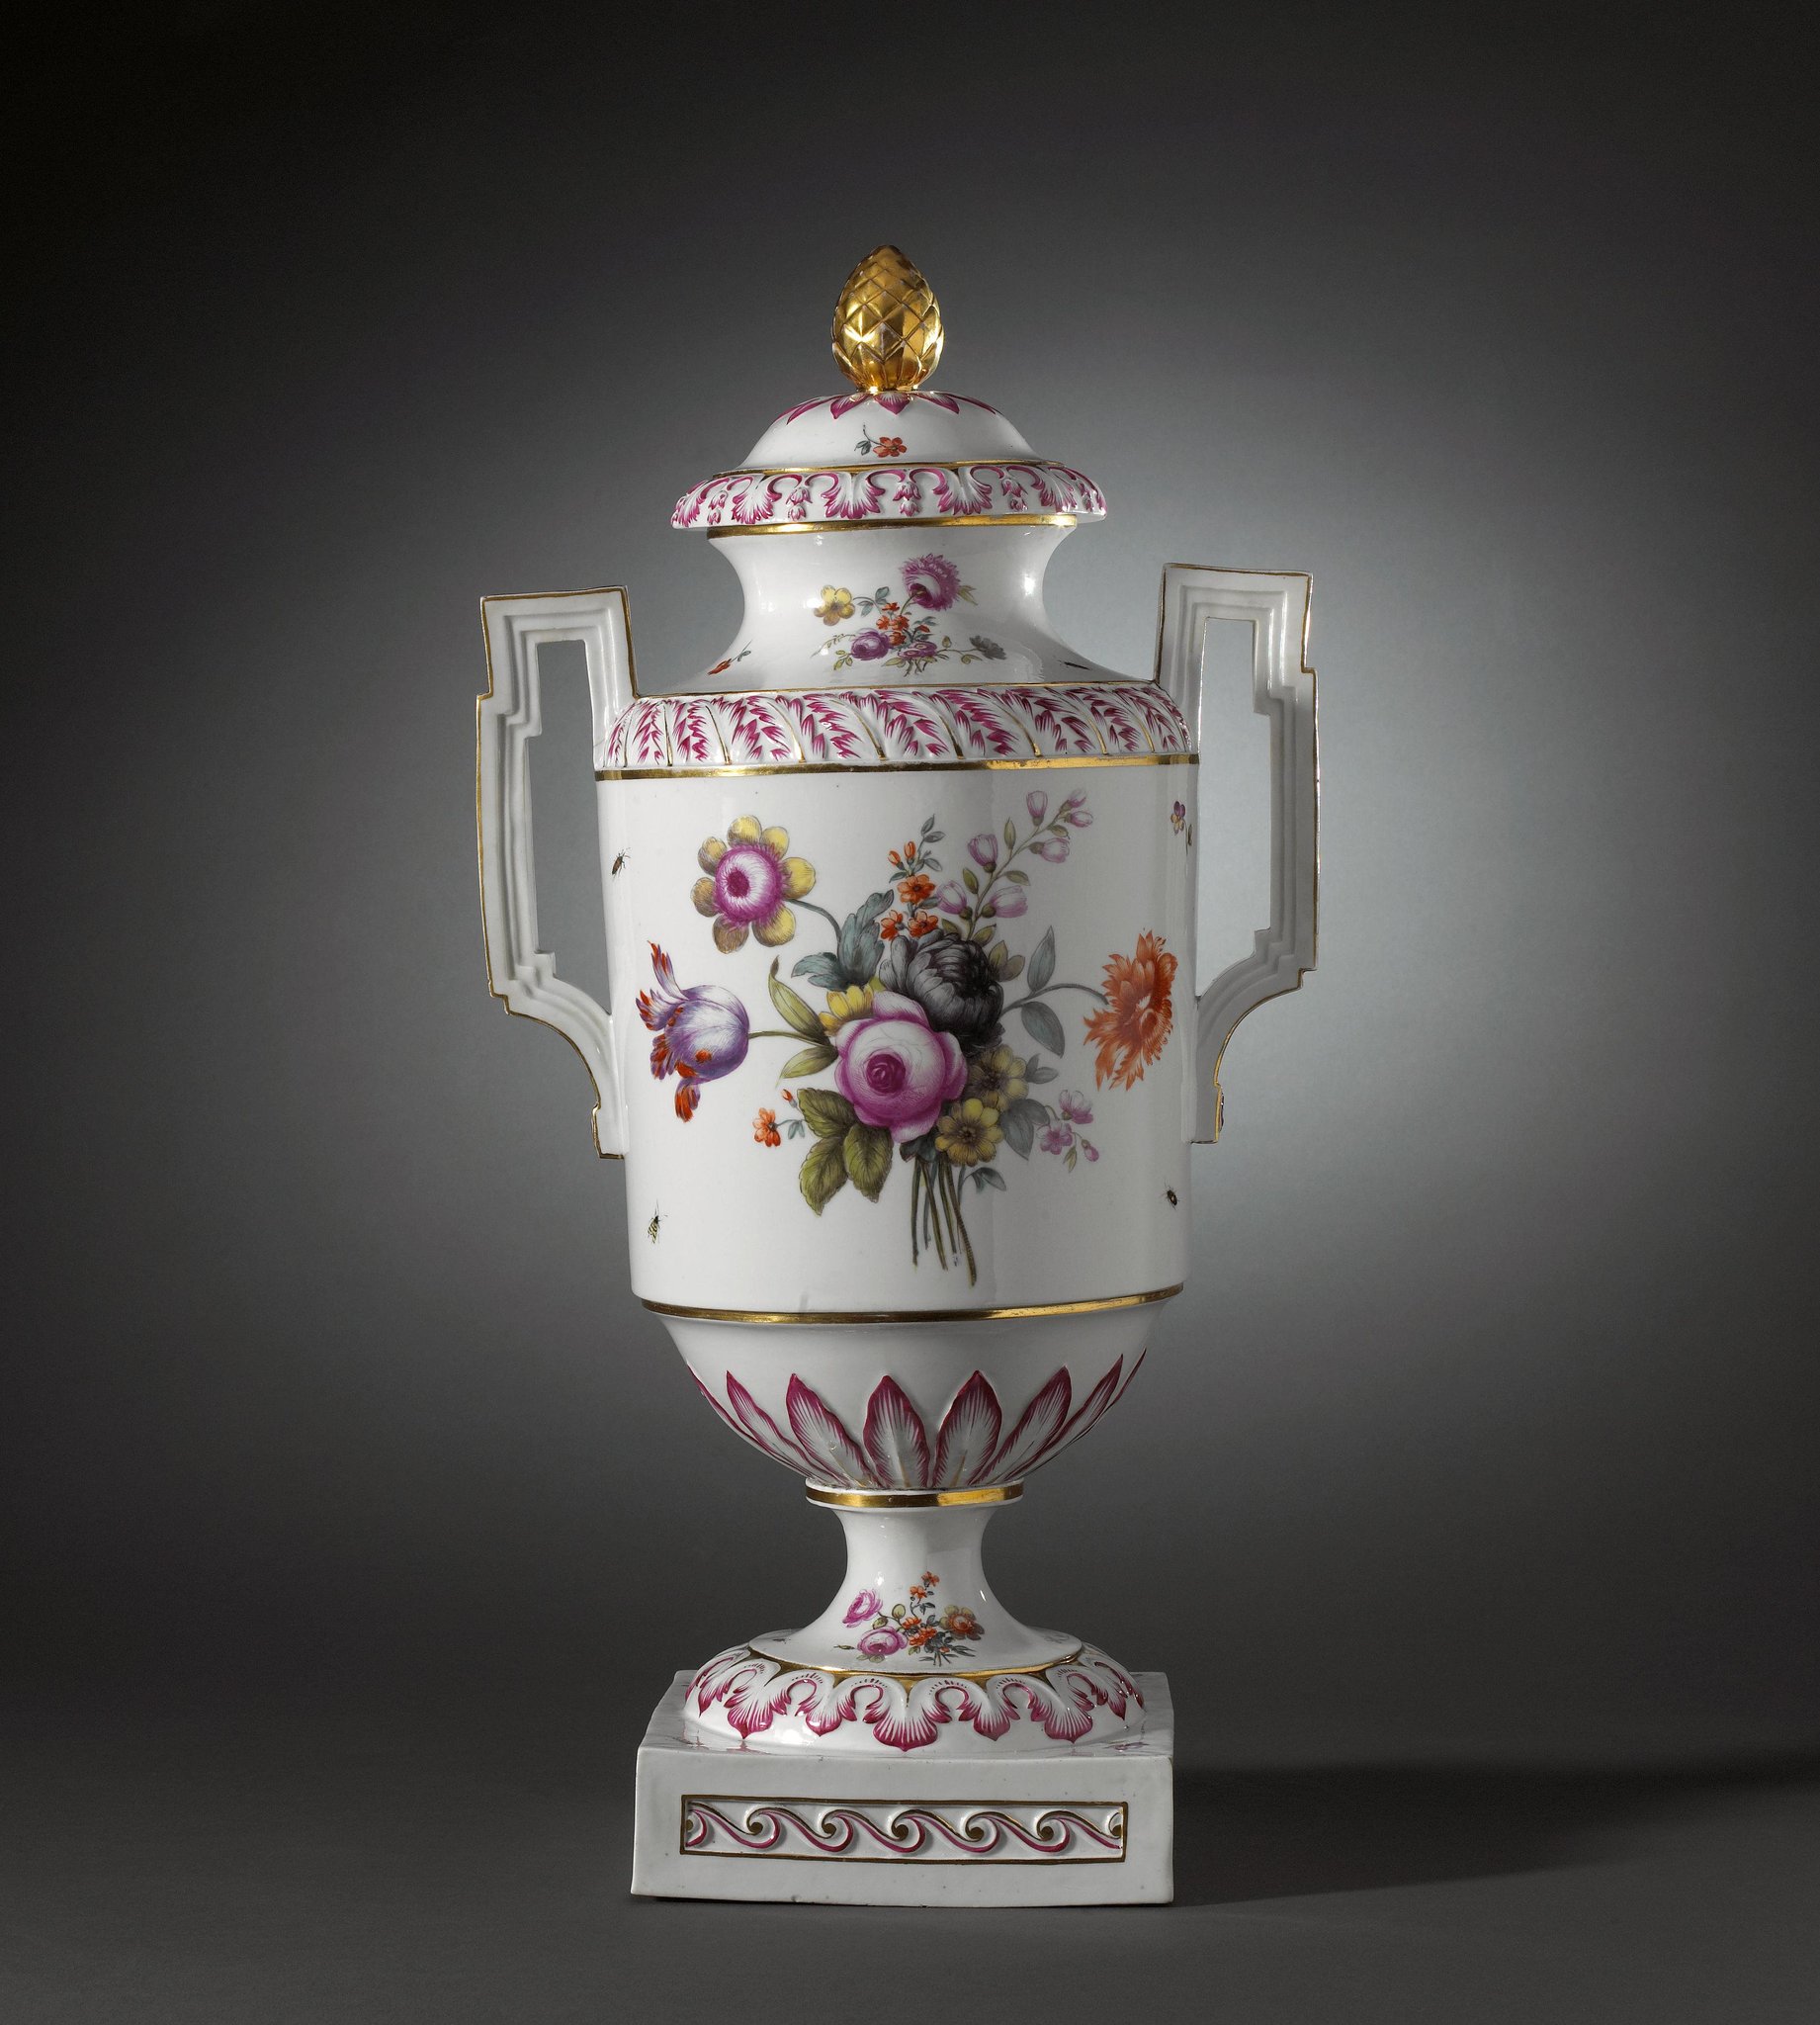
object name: dekselvaas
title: Cover of a vase with flowers and insects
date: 1785-1790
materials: glaze, gold, paint, porcelain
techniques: firing, forming, gilding, relief, turning, vitrification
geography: furstenberg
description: Deksel van een vaas van porselein, beschilderd op het glazuur in blauw, rood, roze, groen, geel, paars, zwart en goud. Versierd met bloemen en insecten en op de rand gemodelleerde bladranken; dekselknop in de vorm van een dennenappel met een gemodelleerde rozet als basis.